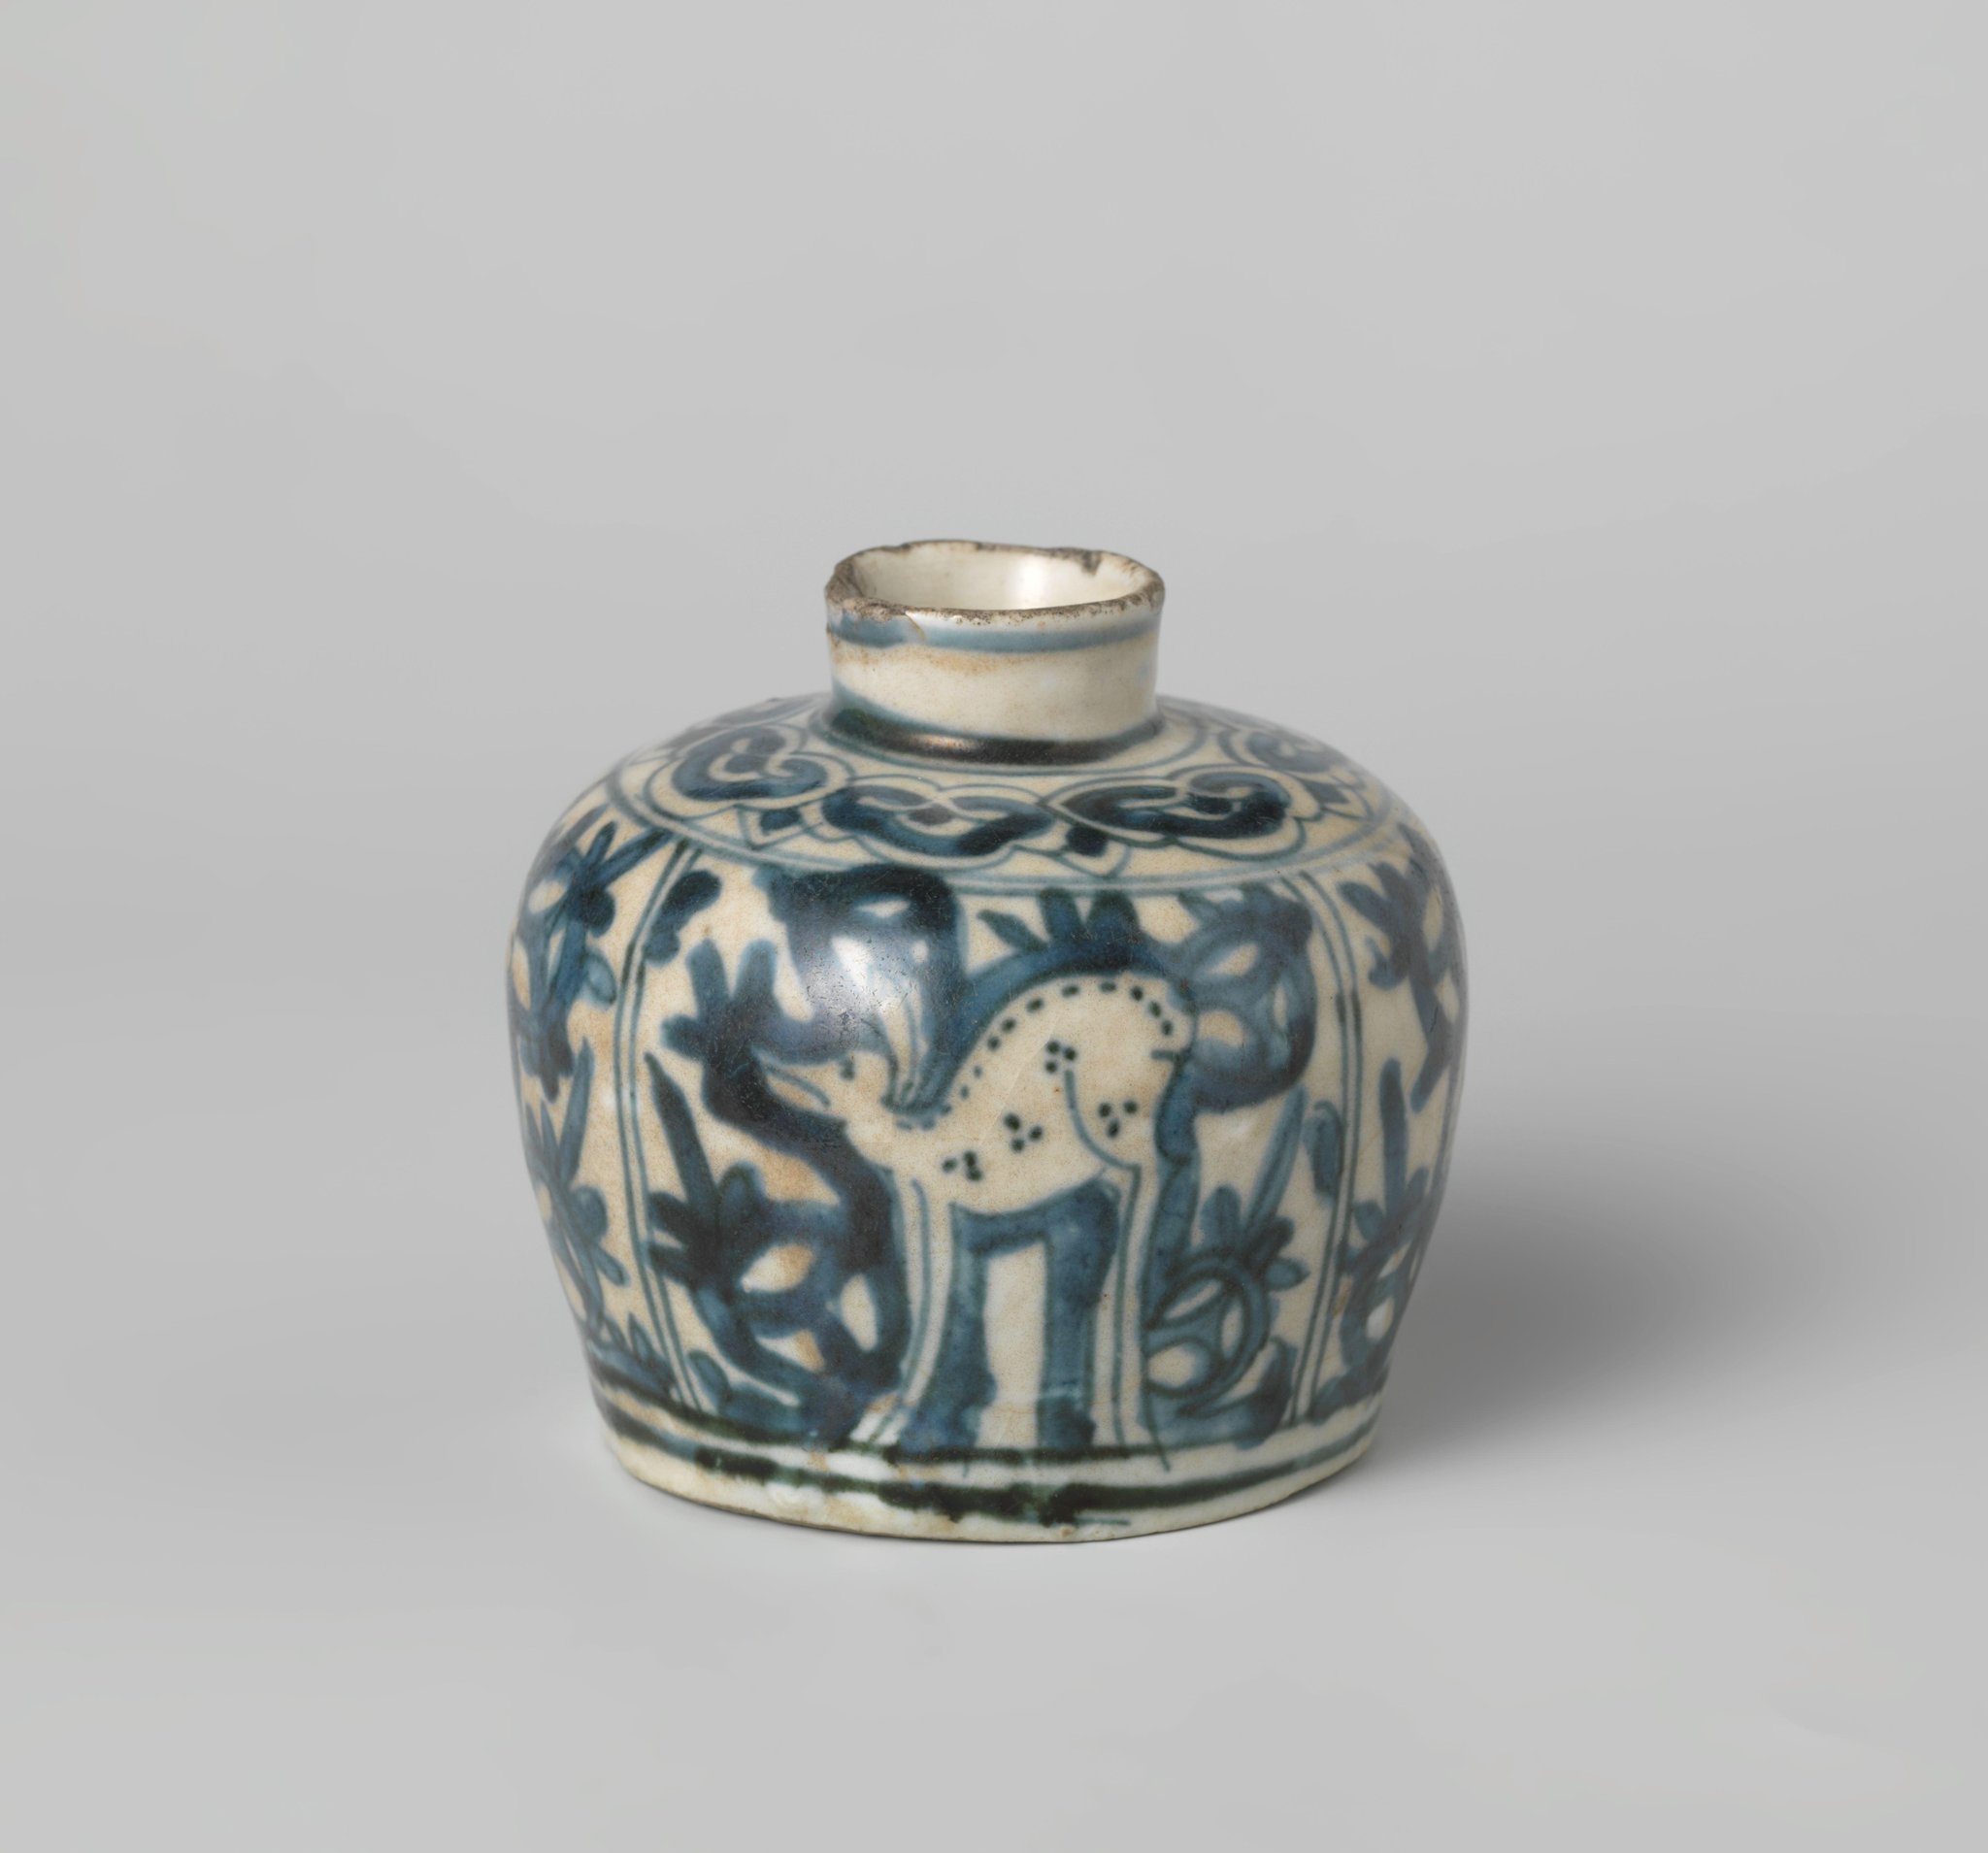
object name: vase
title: Small, shouldered vase with deer among foliage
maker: Anonymous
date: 1600-1624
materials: cobalt, glaze, paint, porcelain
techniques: firing, turning, vitrification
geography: china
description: Kleine vaas van porselein met een brede schouder, beschilderd in onderglazuur blauw. De wand is verdeeld in vier vakken met in elk een hert uitgespaard in een blauwe achtergrond van planten; op de schouder een band met ruyi-motief. Rand is beschadigd. Swatow (zhangzhou).